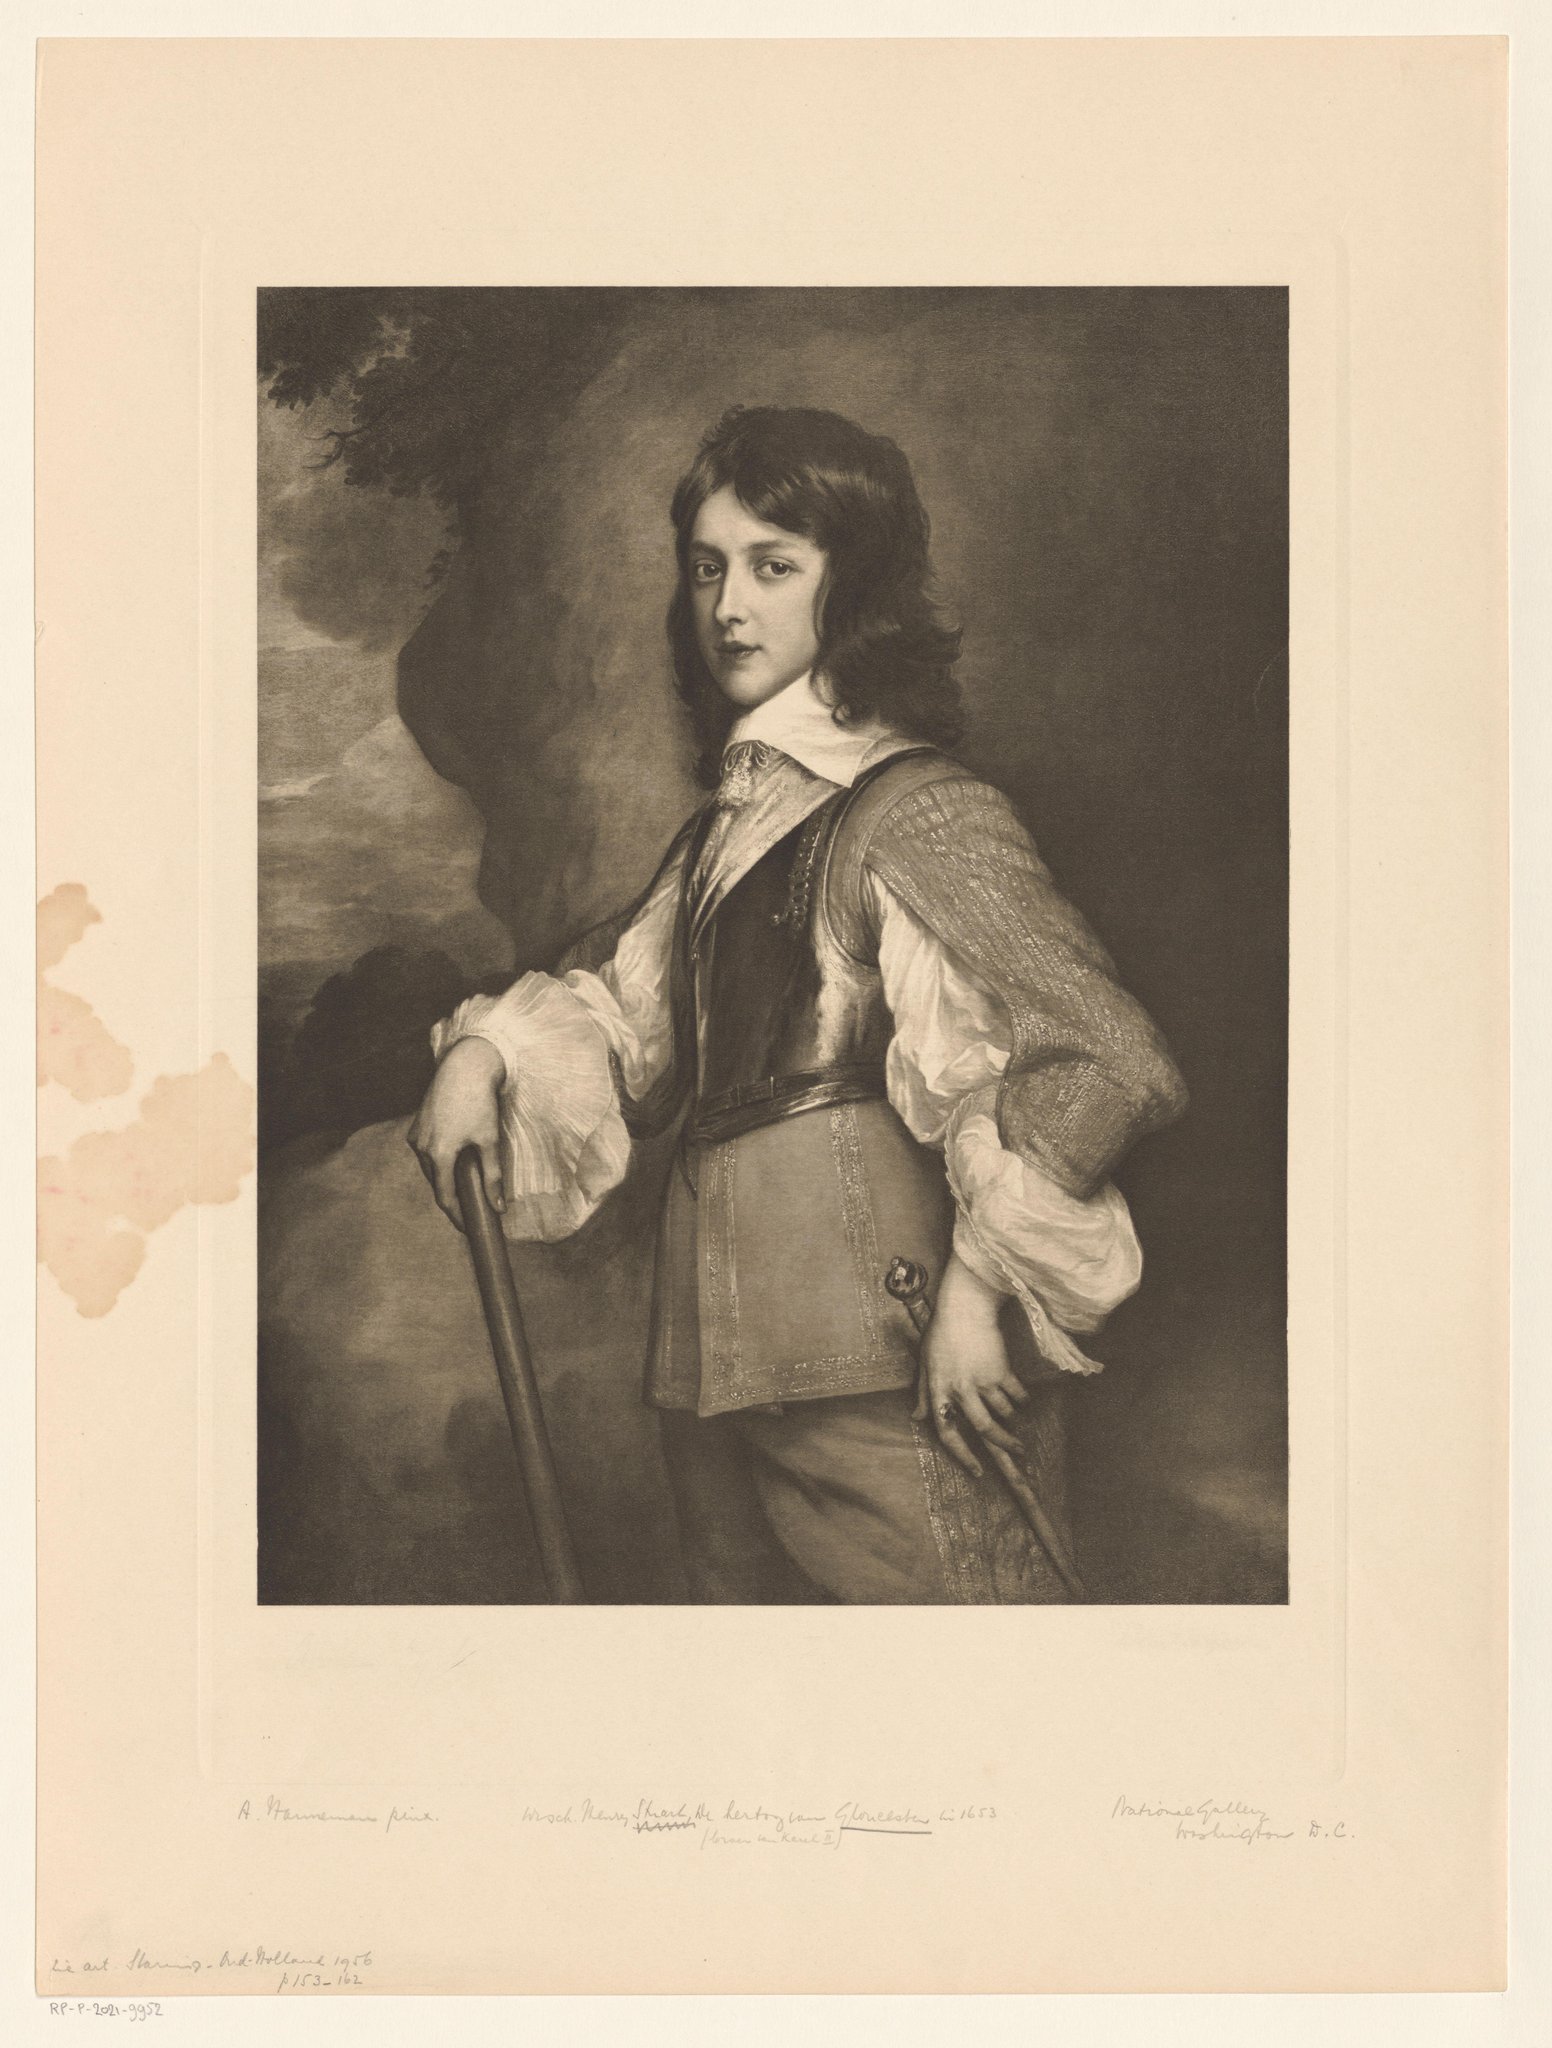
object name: print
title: Portret van Hendrik van Engeland, hertog van Gloucester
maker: Anonymous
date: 1895-1949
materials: paper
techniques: blind stamped, rotogravure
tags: london, historical persons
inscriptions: collector's mark: Lugt 2228